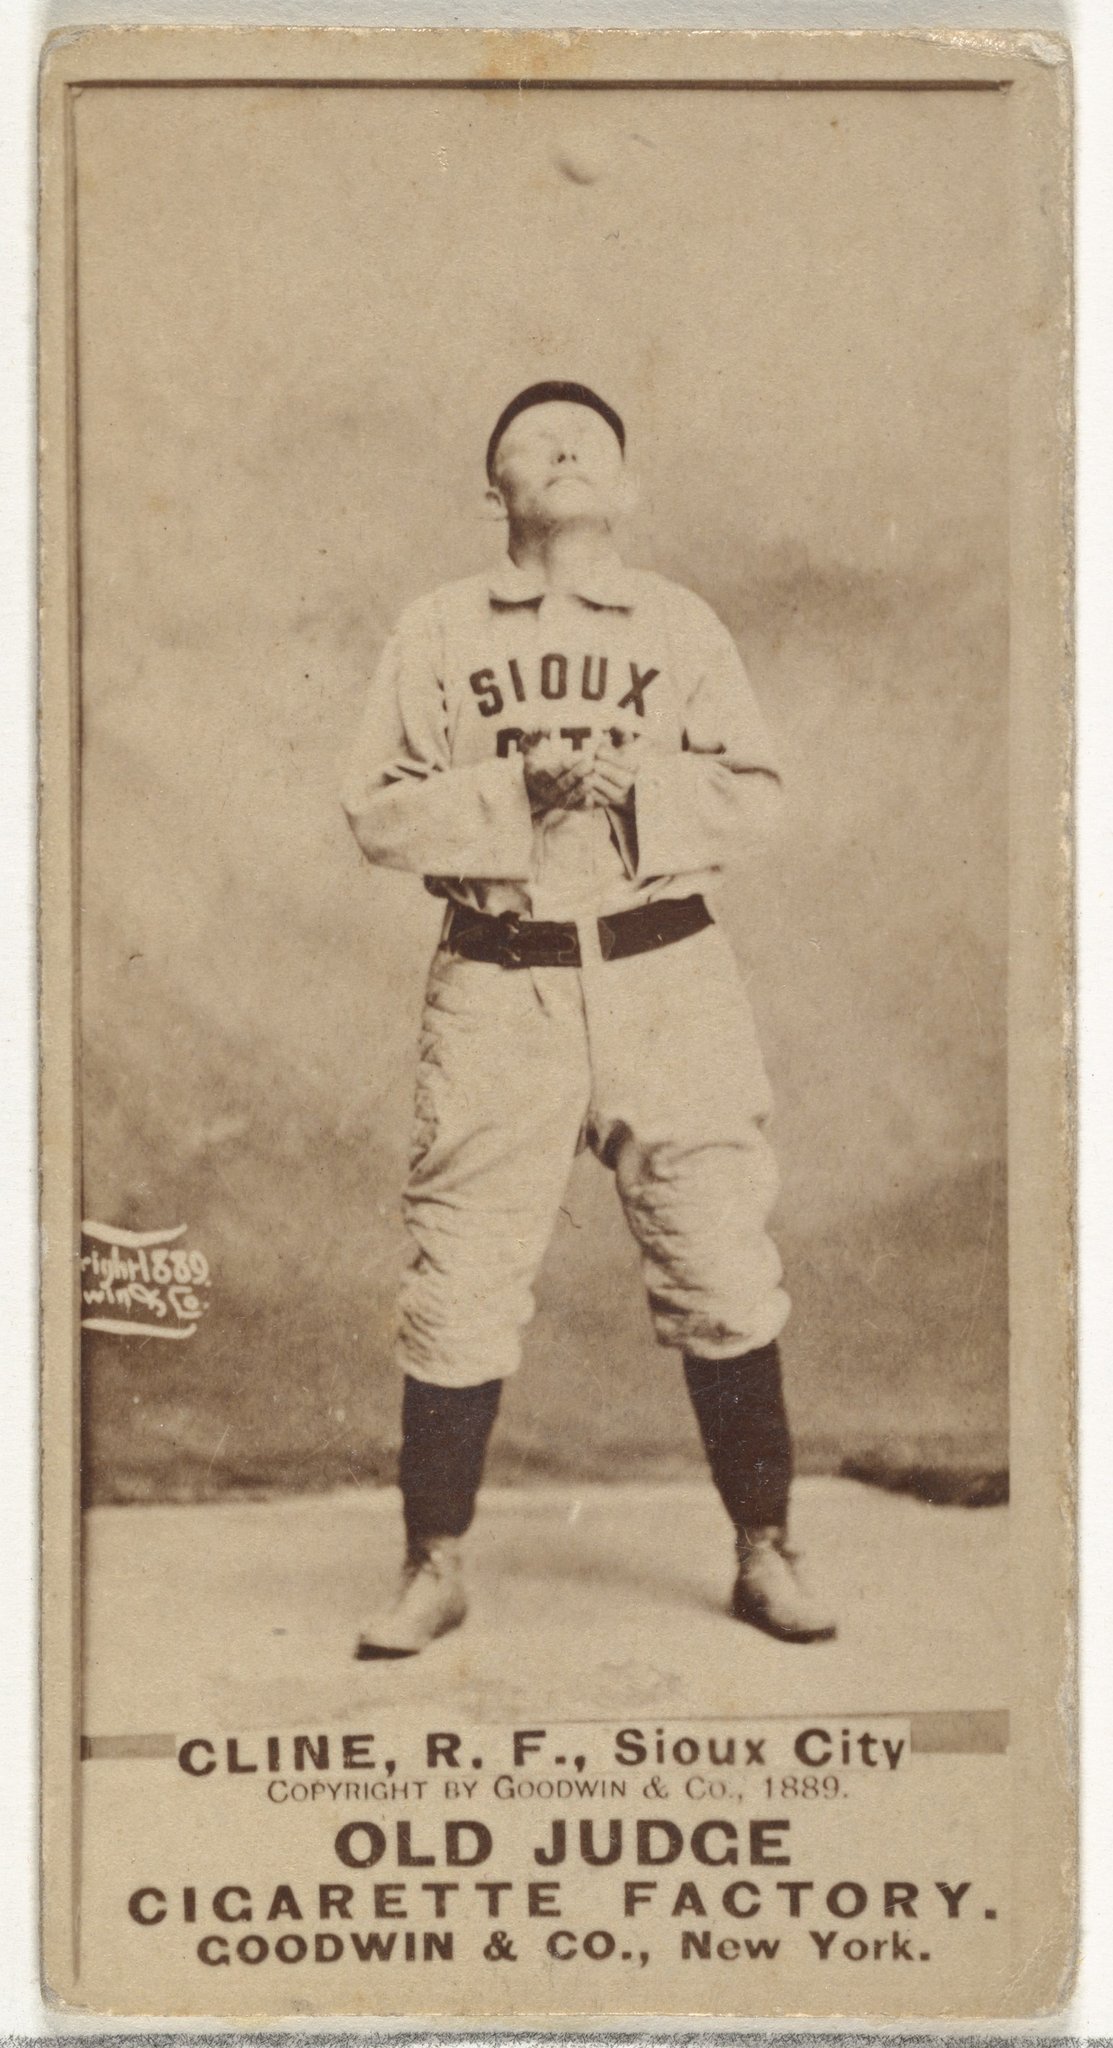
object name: baseball card, photograph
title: John P. "Monk" Cline, Right Field, Sioux City Corn Huskers, from the Old Judge series (N172) for Old Judge Cigarettes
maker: goodwin & company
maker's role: publisher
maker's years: 1850-1950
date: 1889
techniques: albumen silver print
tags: men,portraits,baseball,athletes